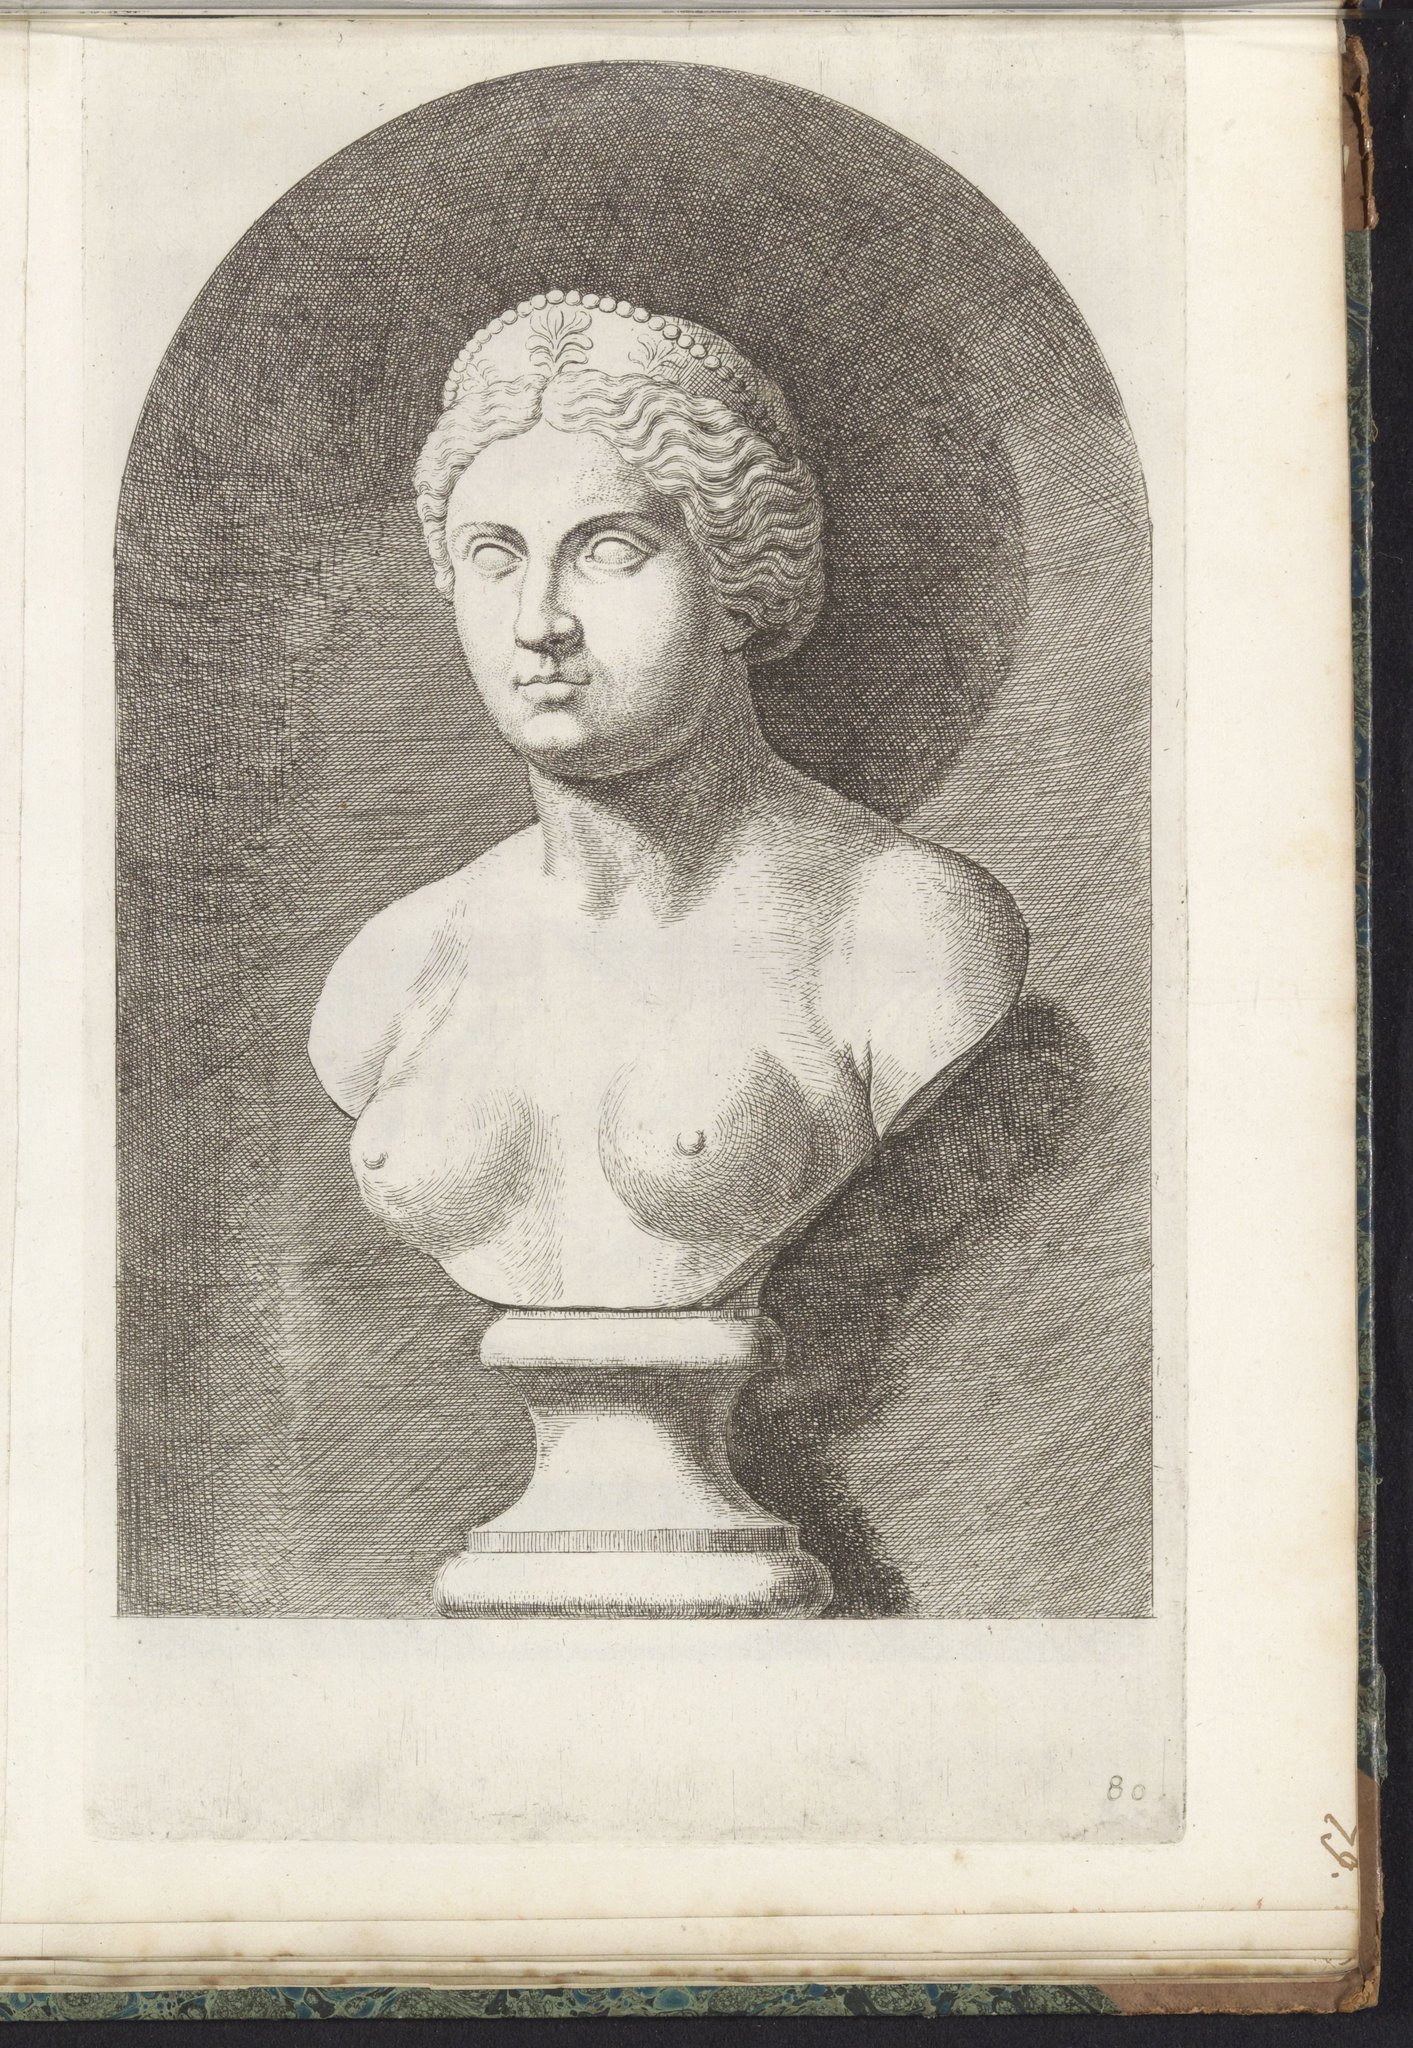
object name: print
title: Buste van een vrouw met een kroon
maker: hubert quellinus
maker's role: print maker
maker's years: 1619-1687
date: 1646-1670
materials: paper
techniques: engraving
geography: antwerp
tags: piece of sculpture, reproduction of a piece of sculpture, female persons from classical history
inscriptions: number: ‘80’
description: De prent maakt deel uit van een album met een serie prenten naar de sculpturen in de verzameling van Gerard Reynst.